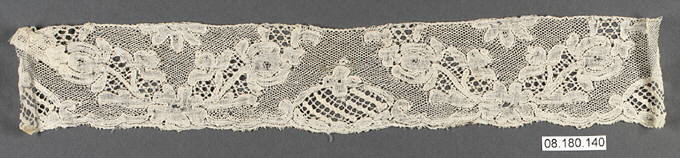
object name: piece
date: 1701-1800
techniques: lace